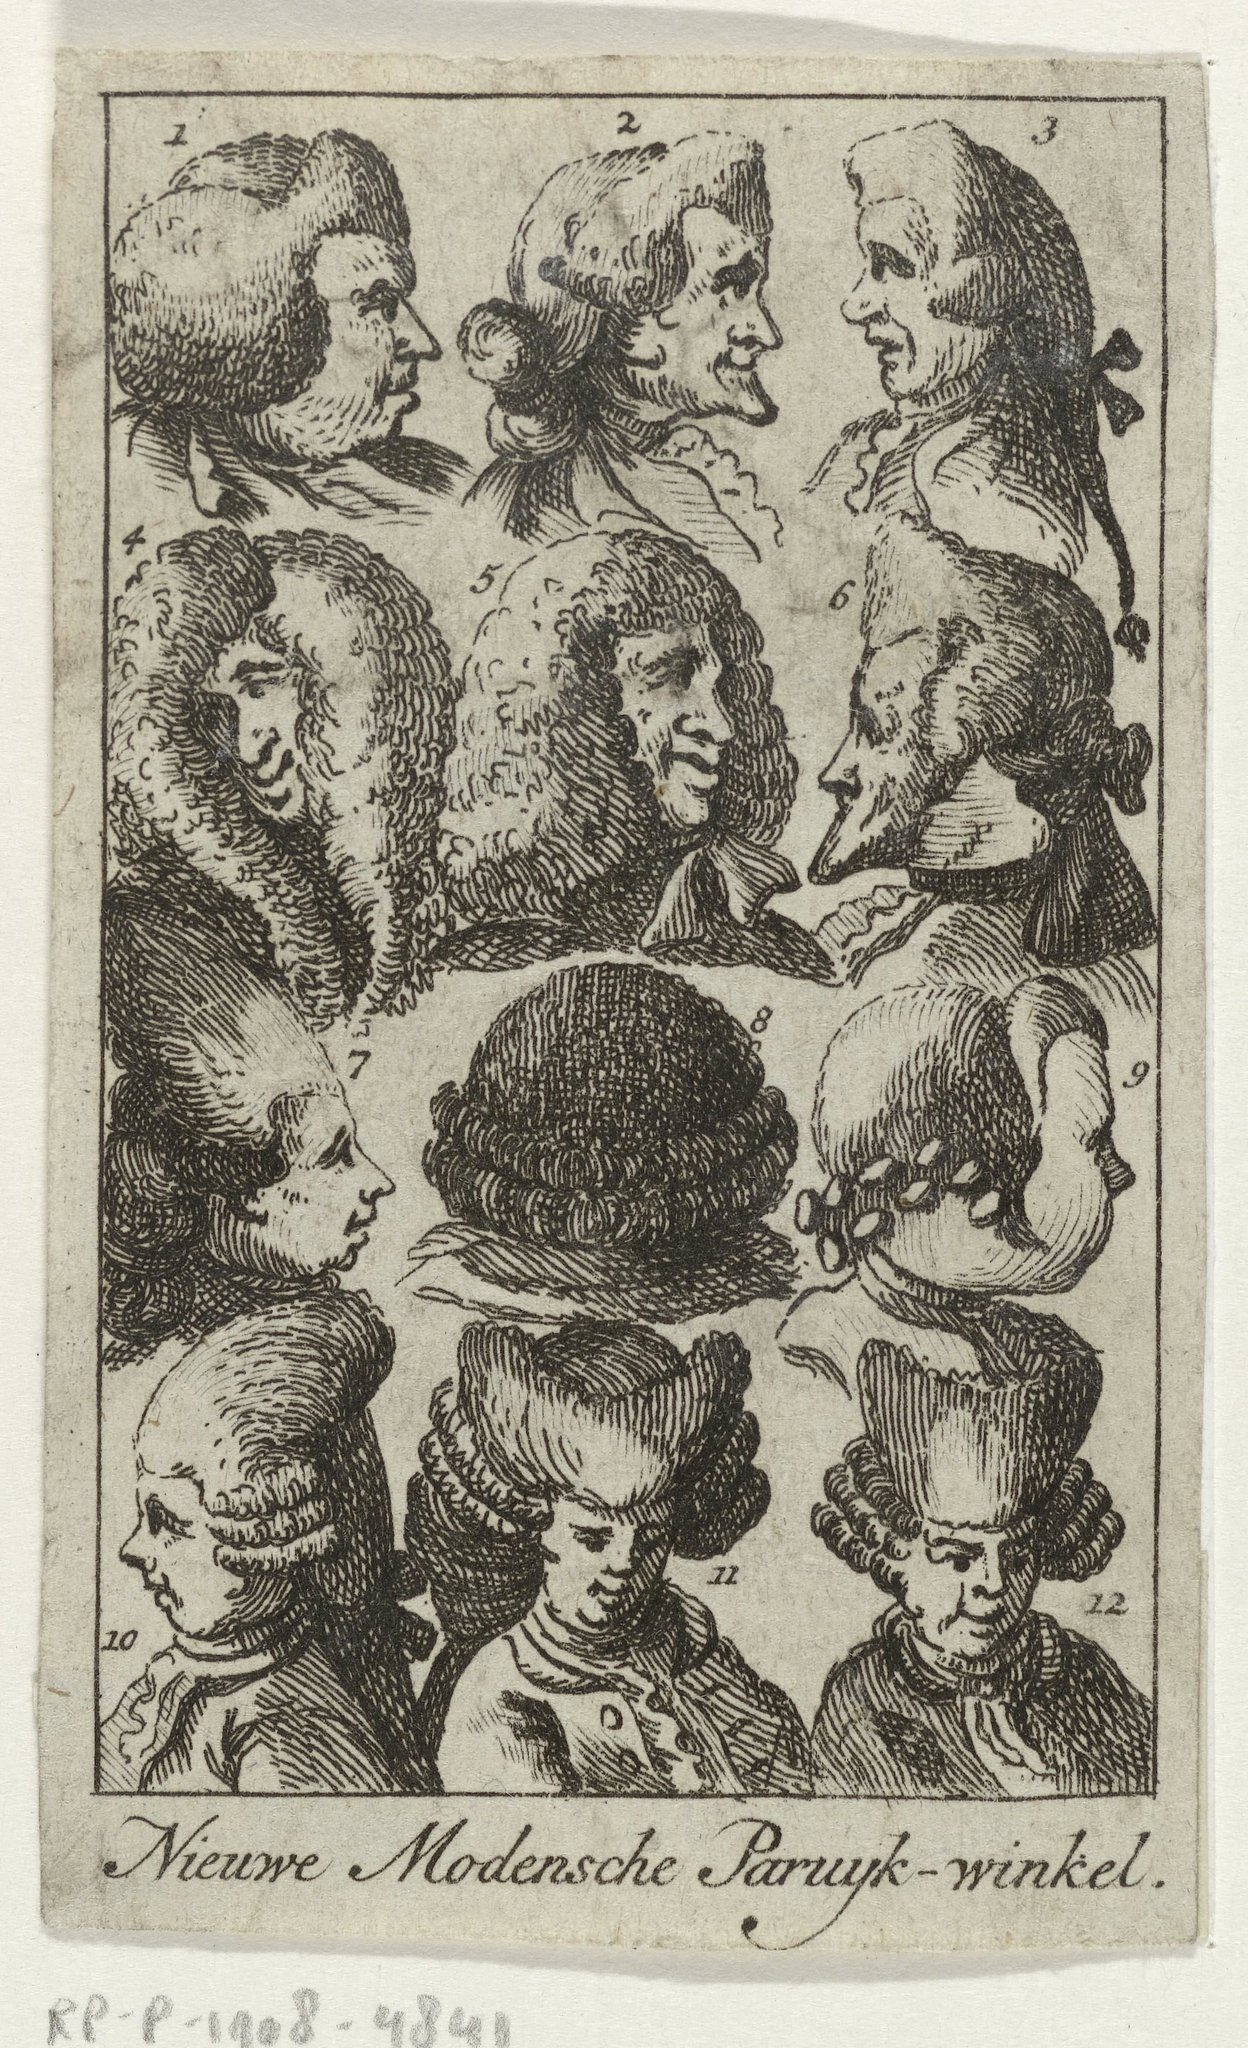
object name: print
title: Nieuwe Modensche Paruyk-winkel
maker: Anonymous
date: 1700-1800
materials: paper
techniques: etching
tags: wig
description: Twaalf verschillende mannenpruiken, in vier rijen van drie.